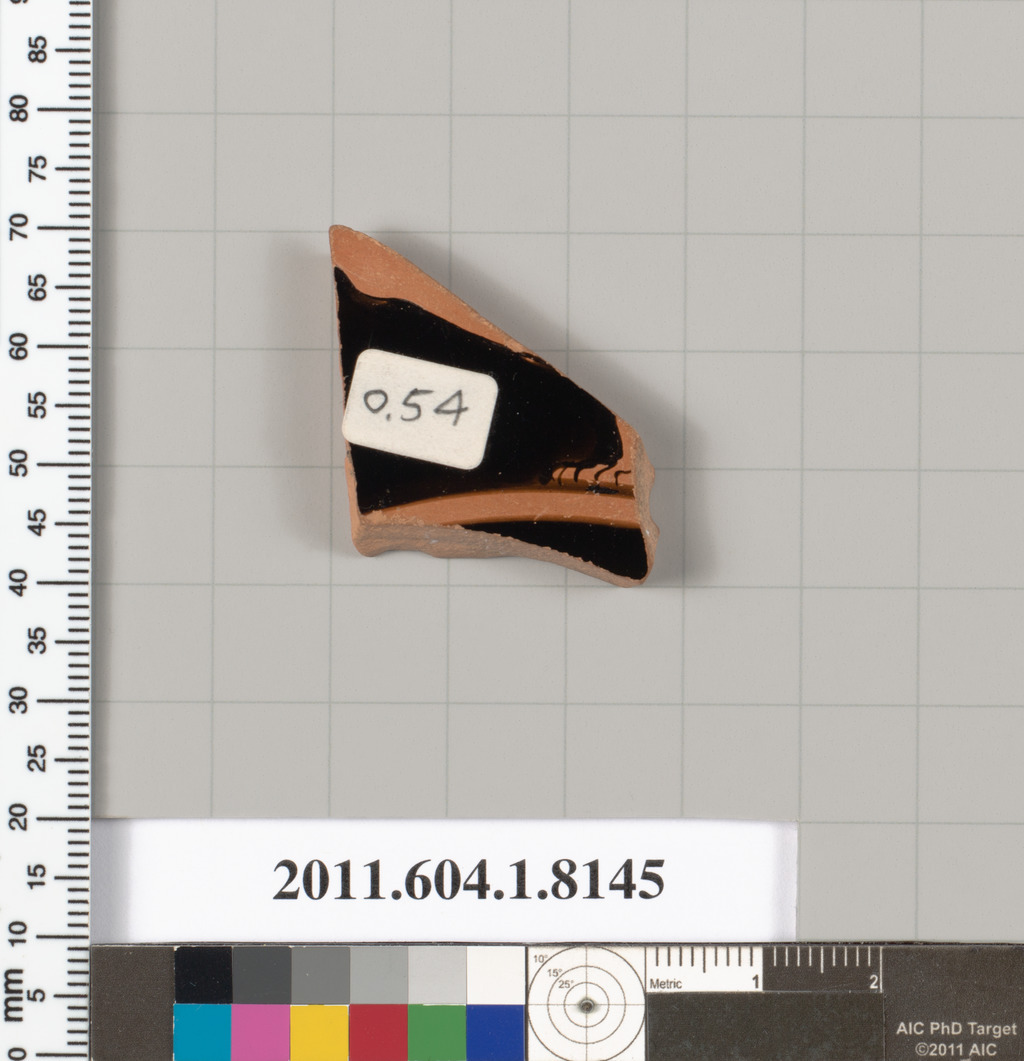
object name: kylix fragment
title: Terracotta fragment of a kylix (drinking cup)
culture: greek, attic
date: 520-500 BCE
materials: terracotta